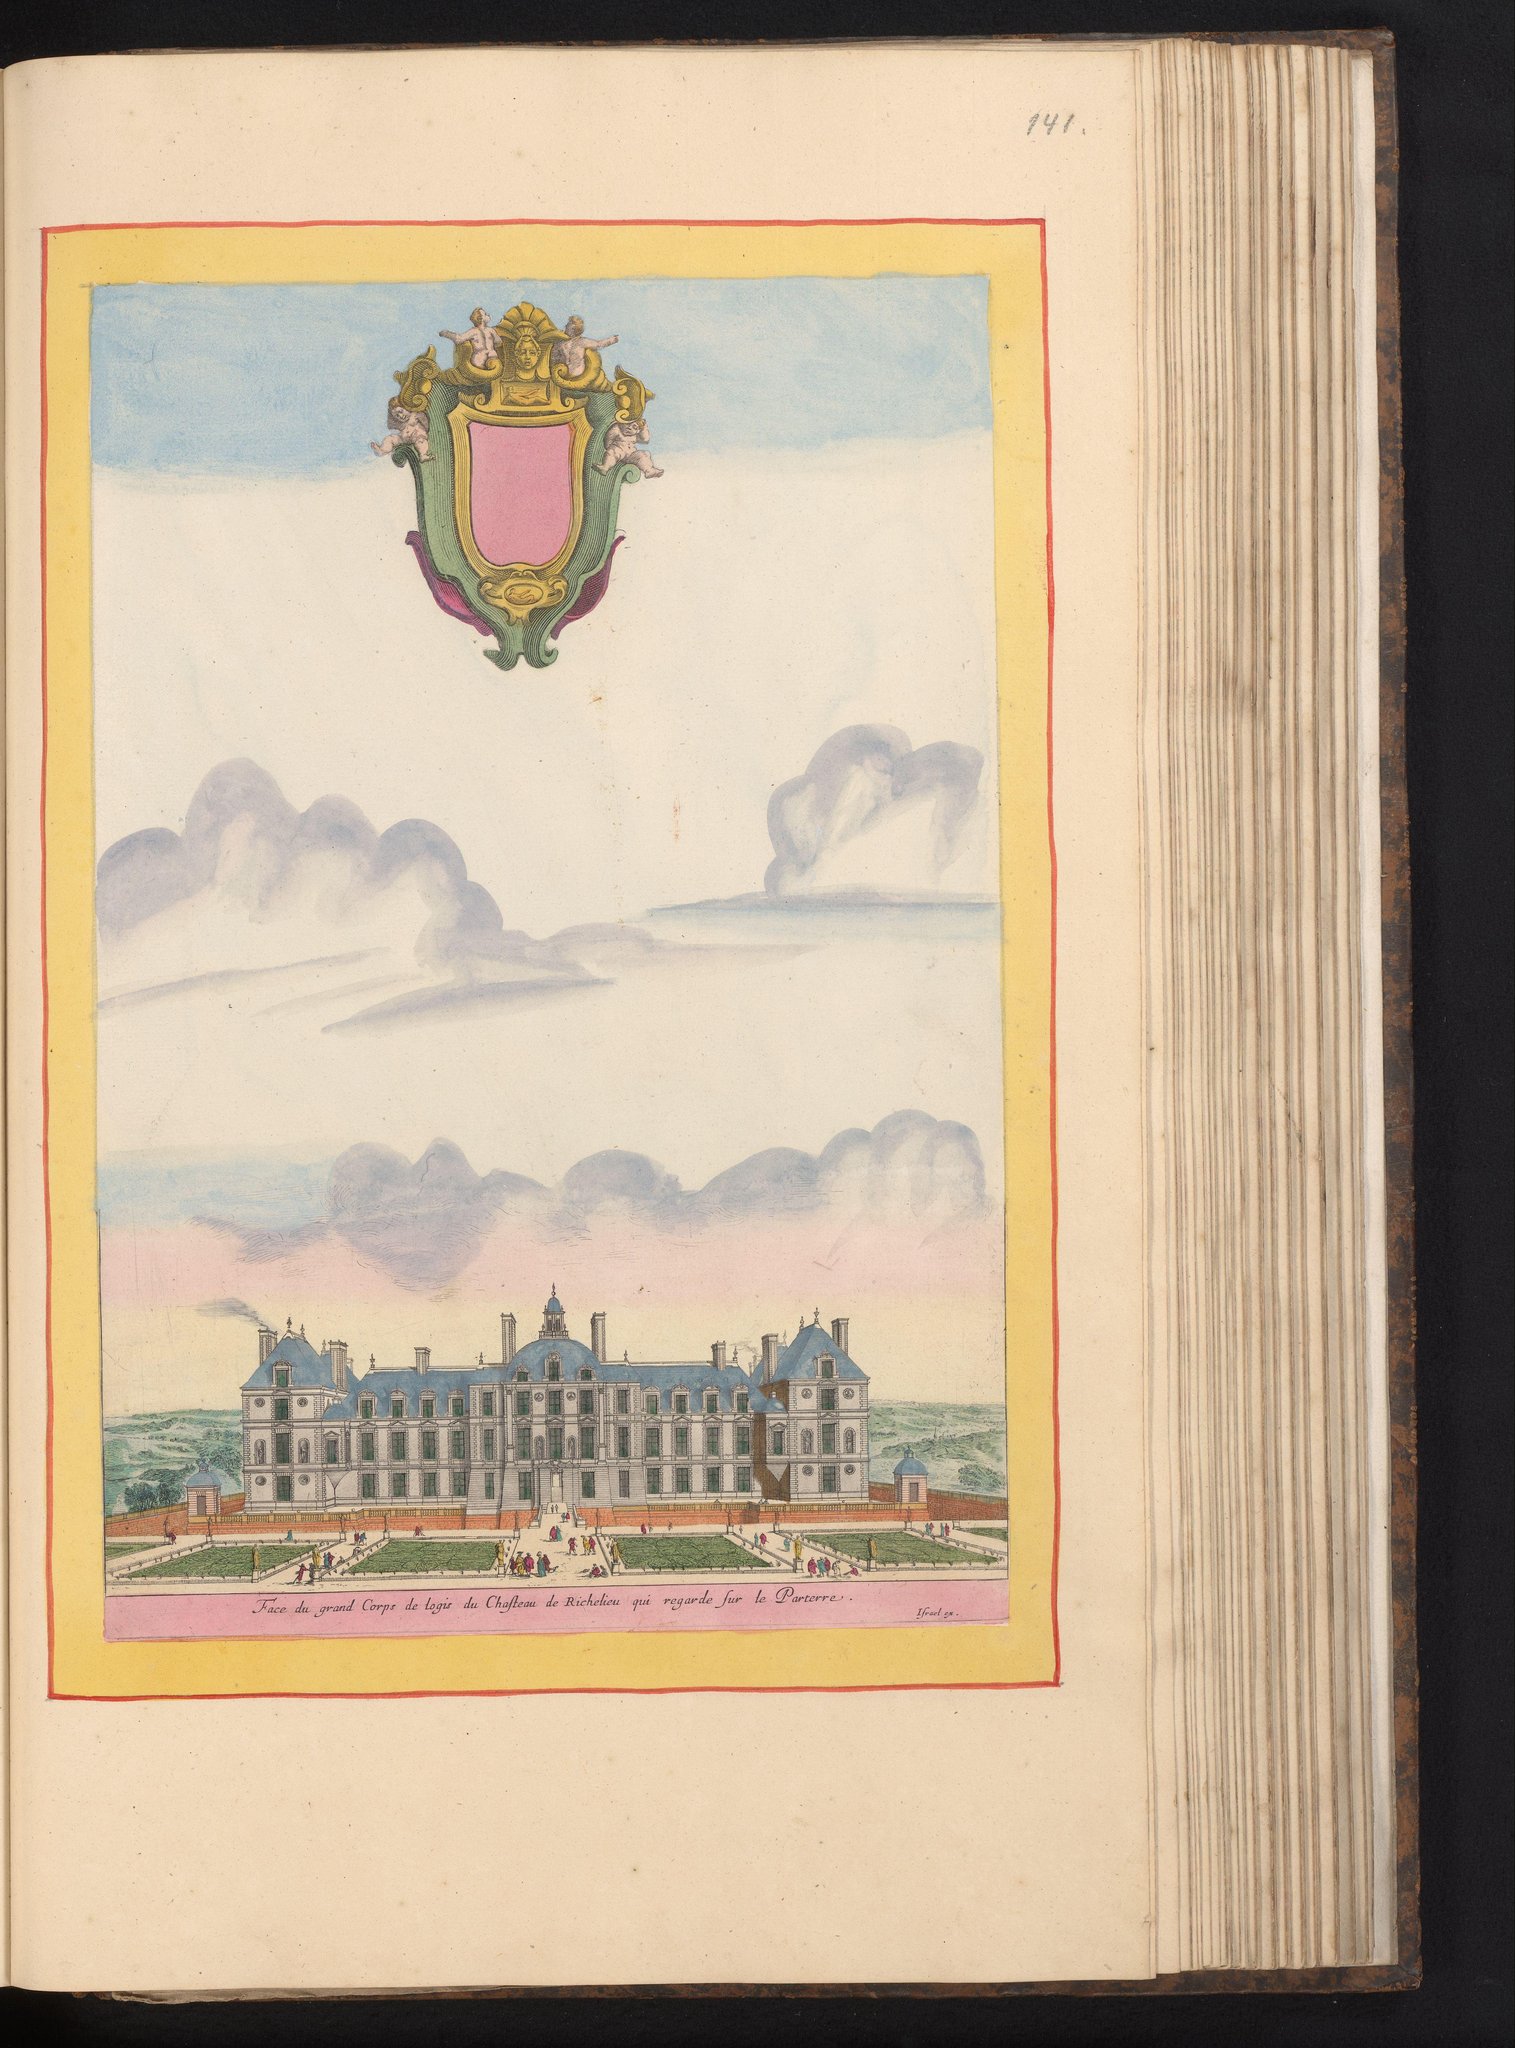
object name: album leaf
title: Gezichten op diverse kastelen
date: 1649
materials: paper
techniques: engraving, etching, hand coloring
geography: the hague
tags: castle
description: Uit een serie van twaalf ongenummerde prenten.